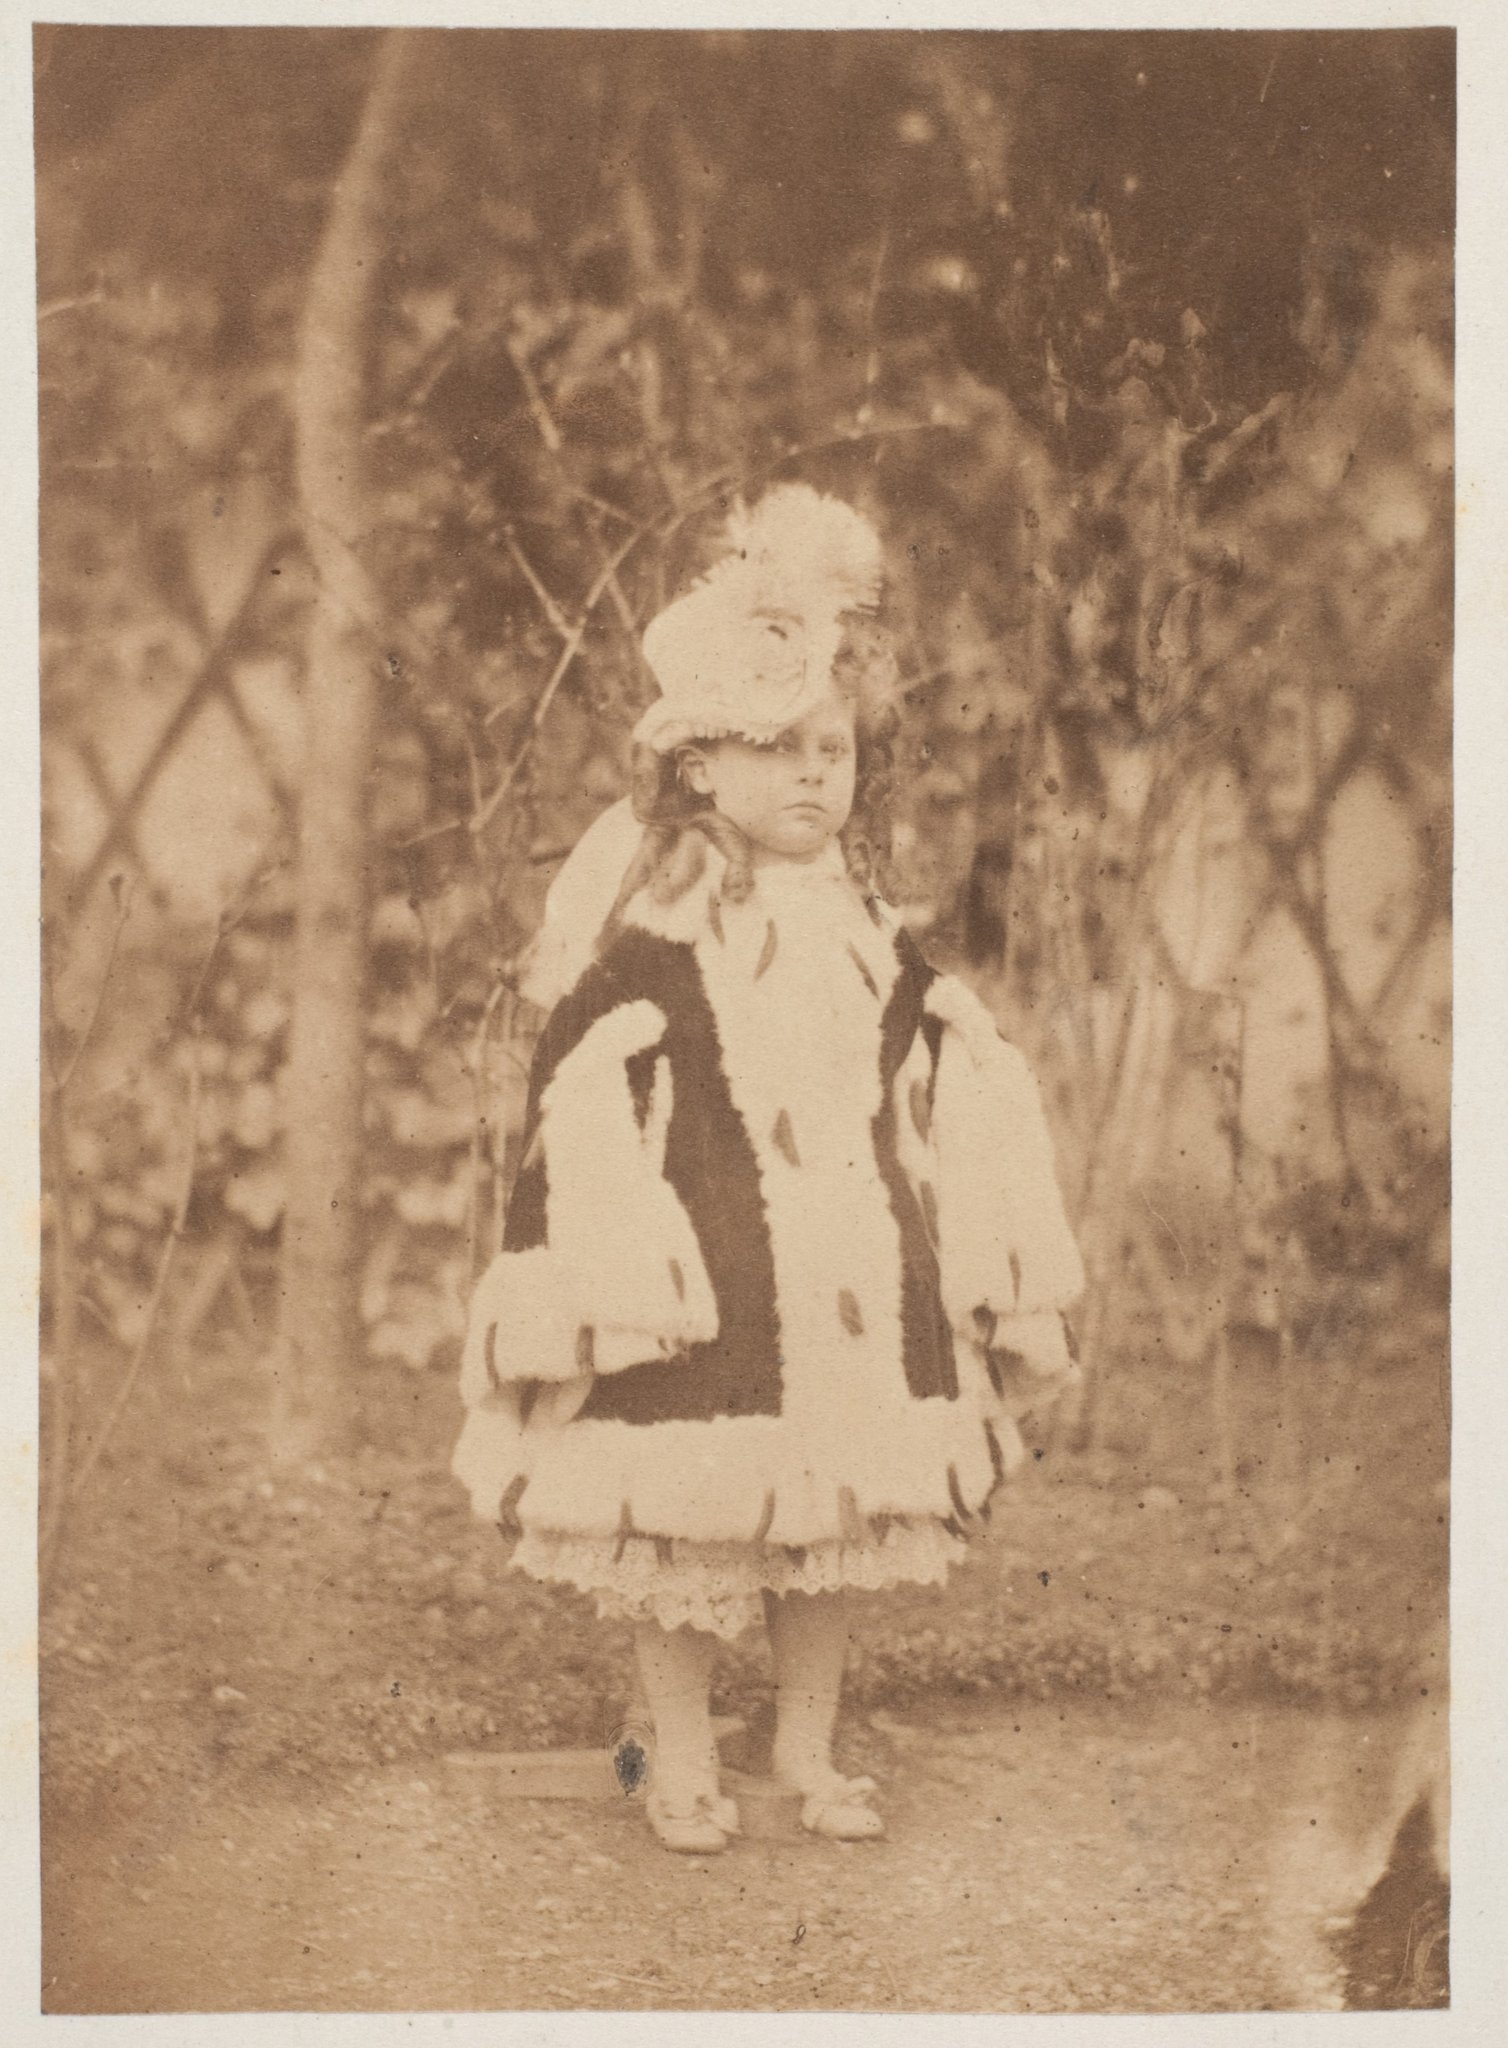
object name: photograph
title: La fouriure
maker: pierre-louis pierson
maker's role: artist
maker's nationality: french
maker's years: 1822-1913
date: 1860-1869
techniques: albumen silver print, glass negative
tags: girls,portraits